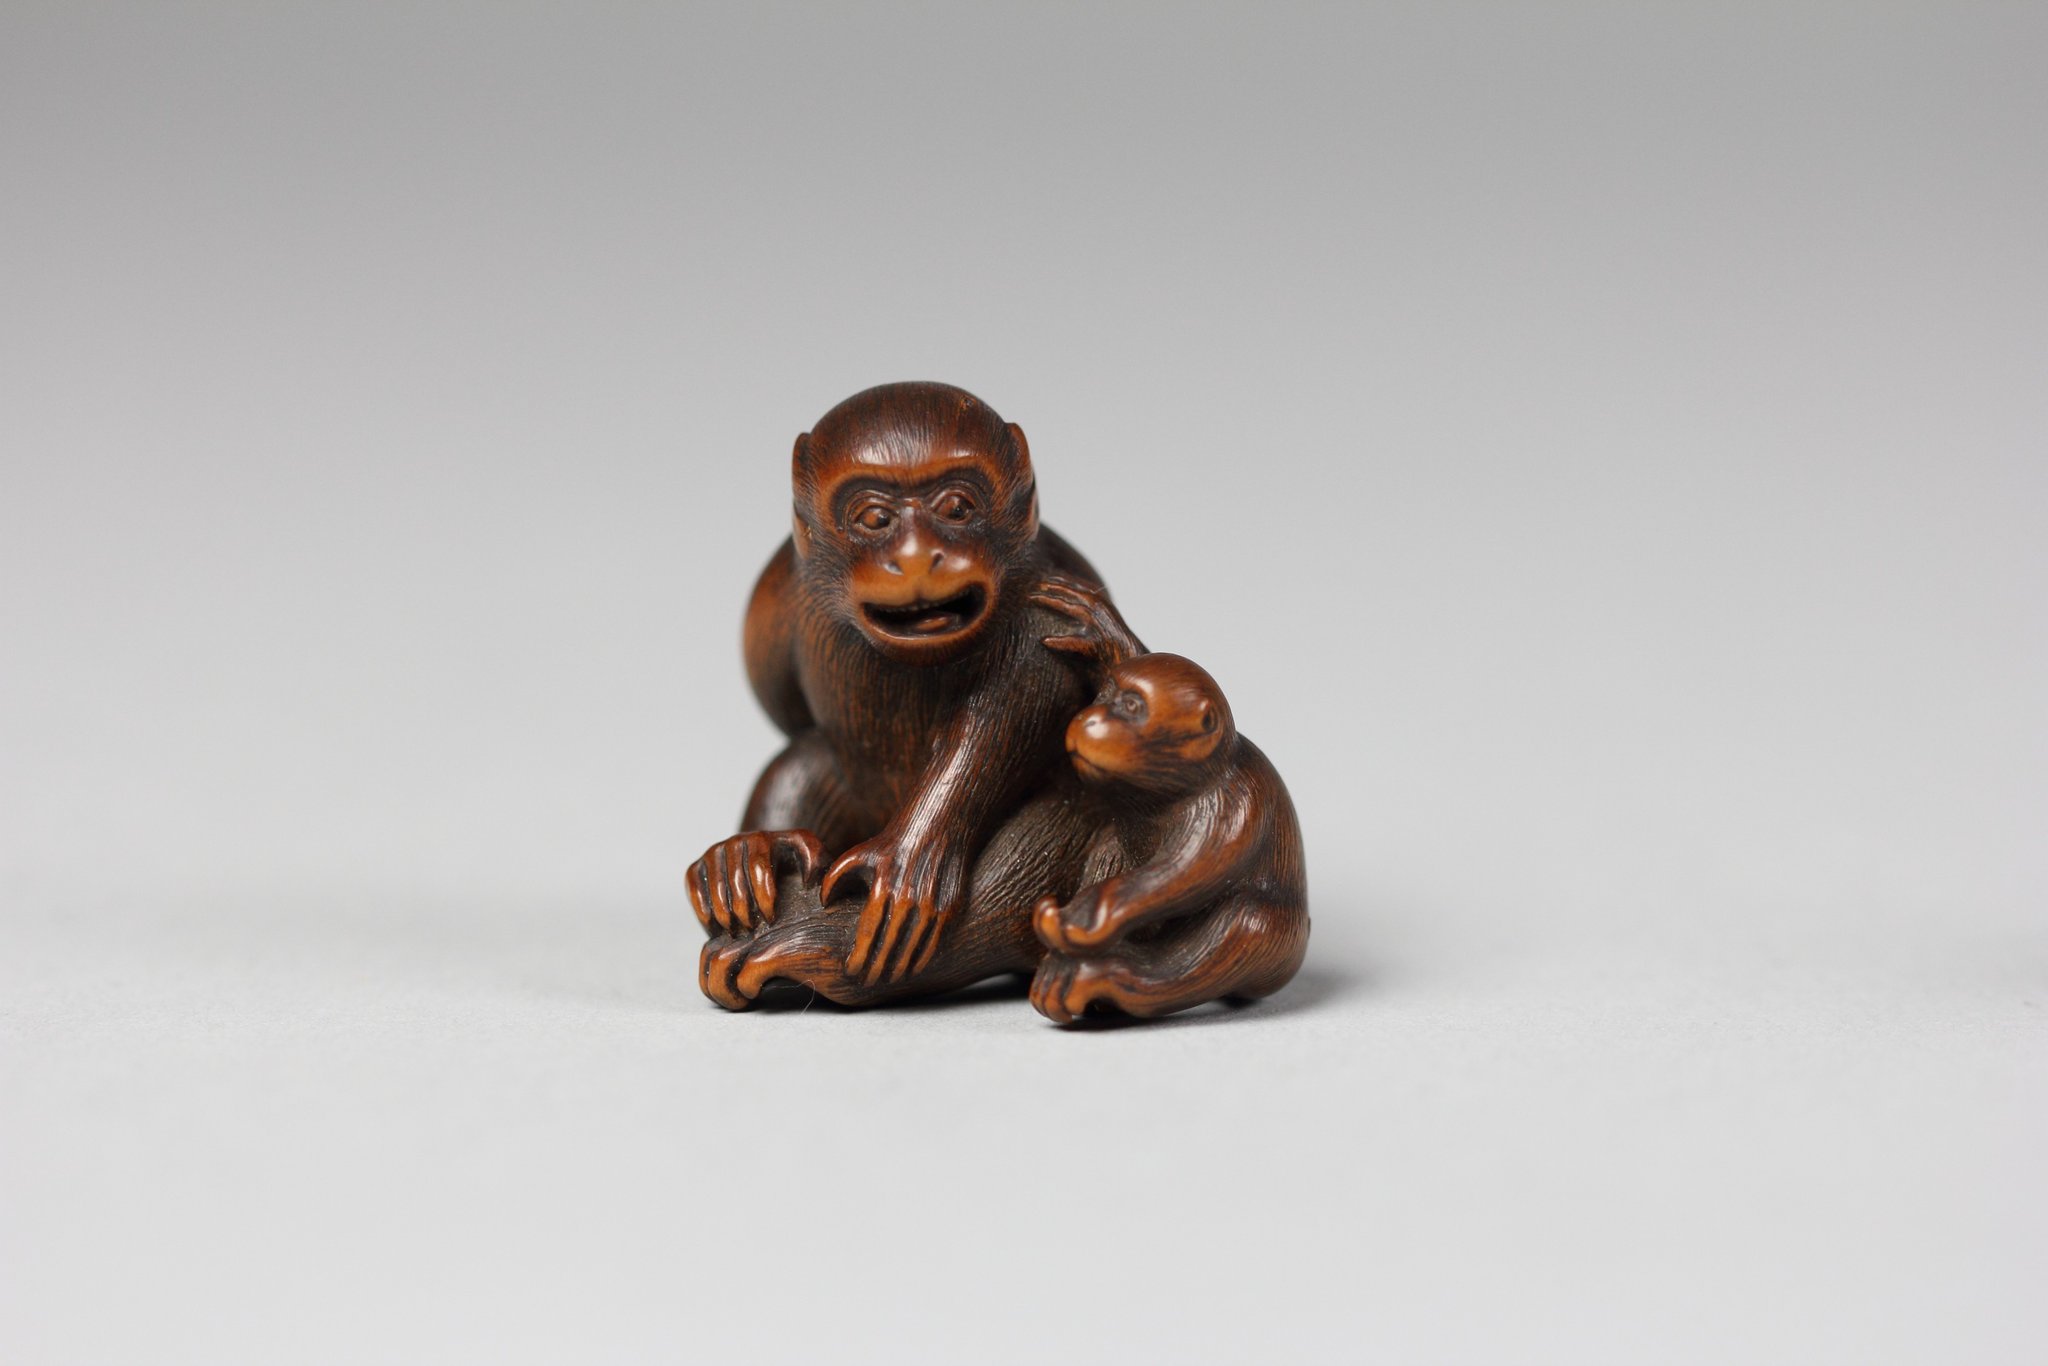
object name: netsuke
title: Netsuke of Monkey and Young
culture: japanese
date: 1801-1900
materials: wood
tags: monkeys